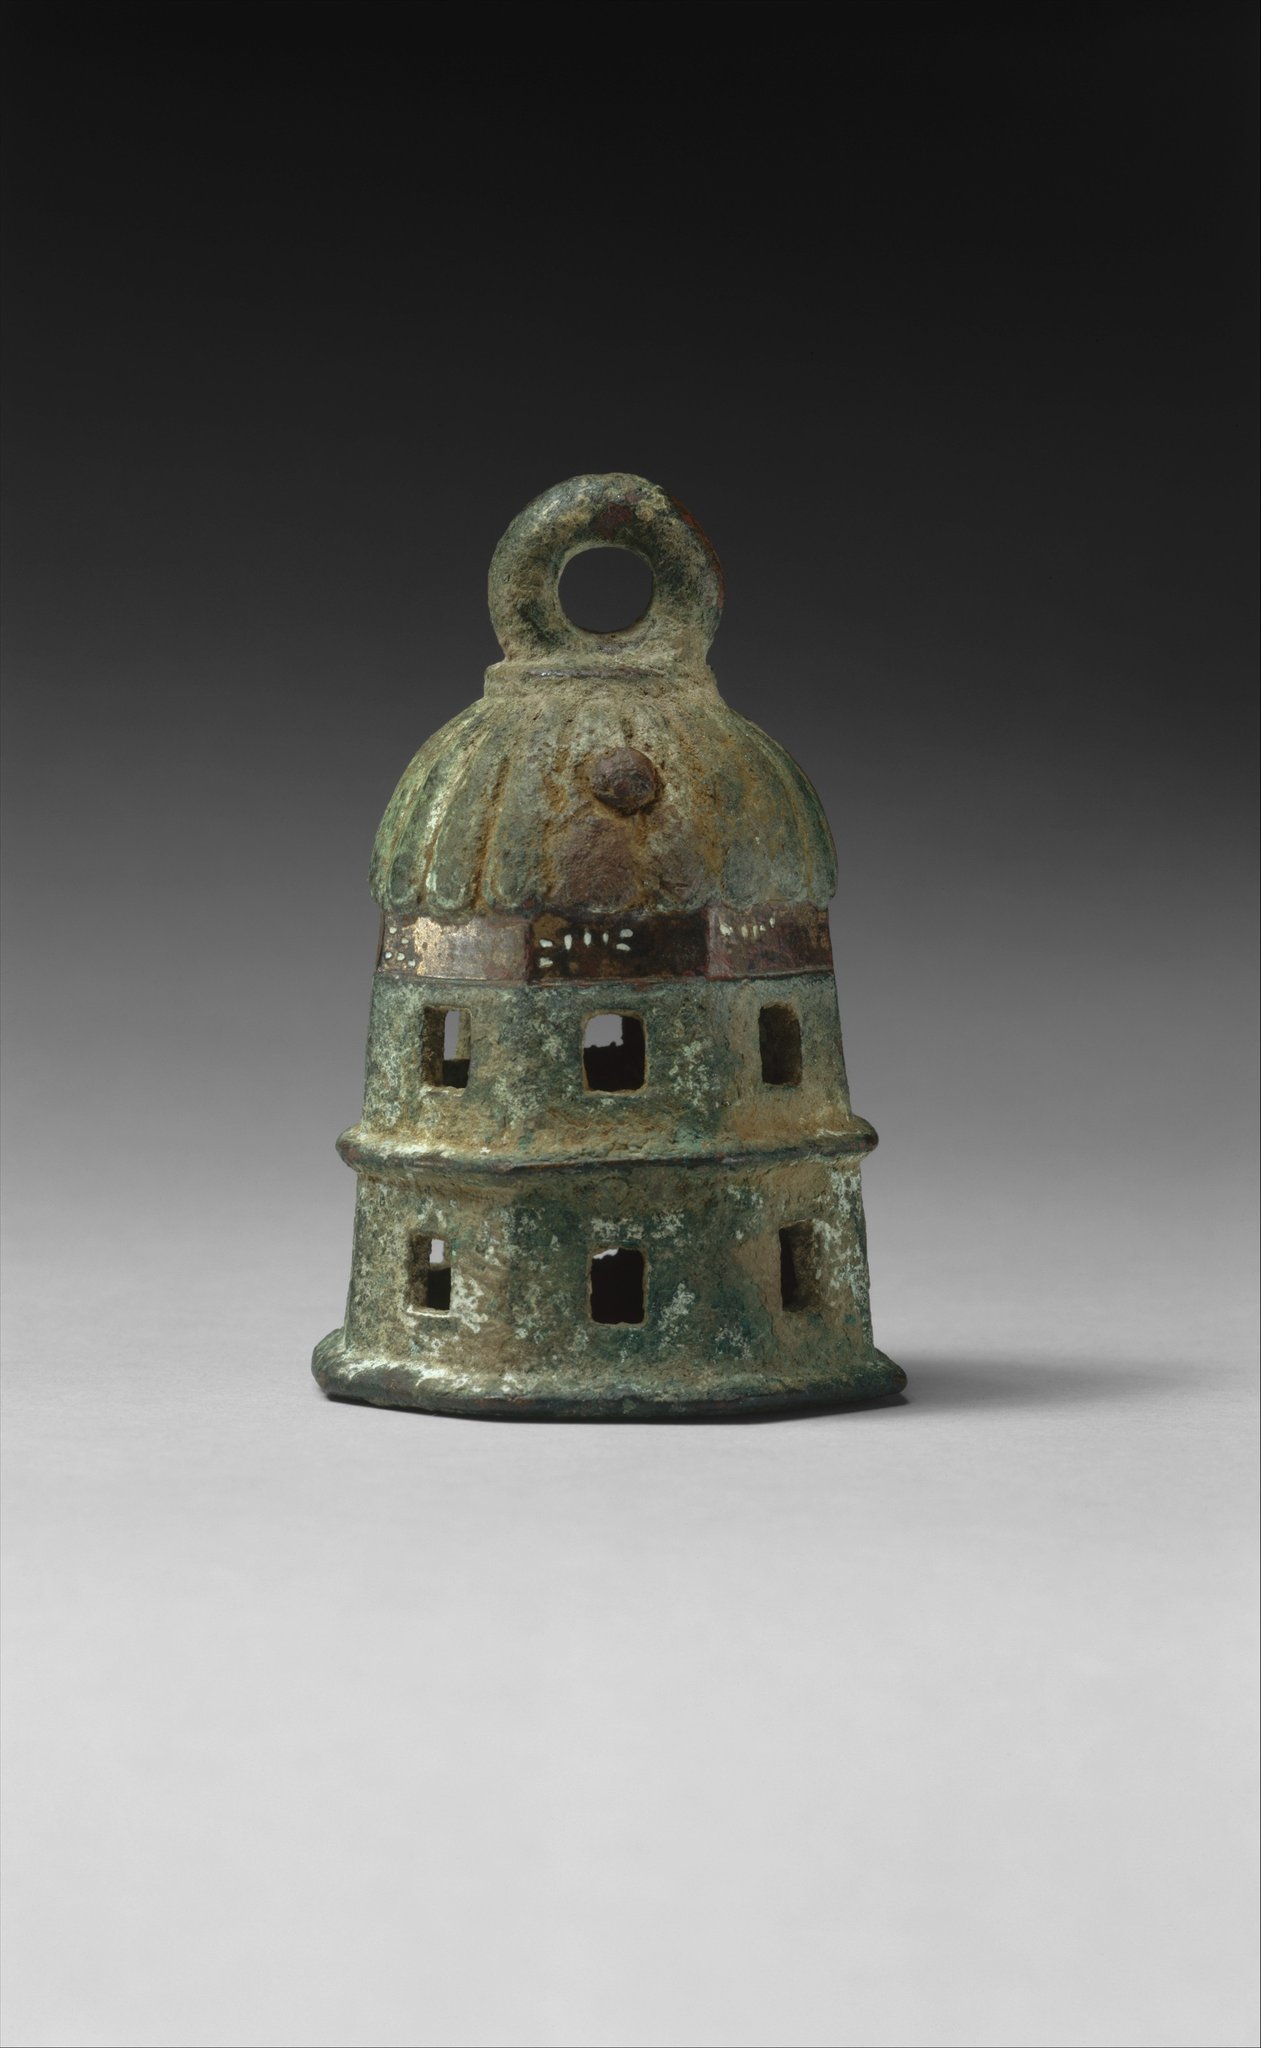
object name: bell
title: Bell inscribed with the Urartian royal name Argishti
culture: urartian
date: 789-766 BCE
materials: bronze, iron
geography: urartu